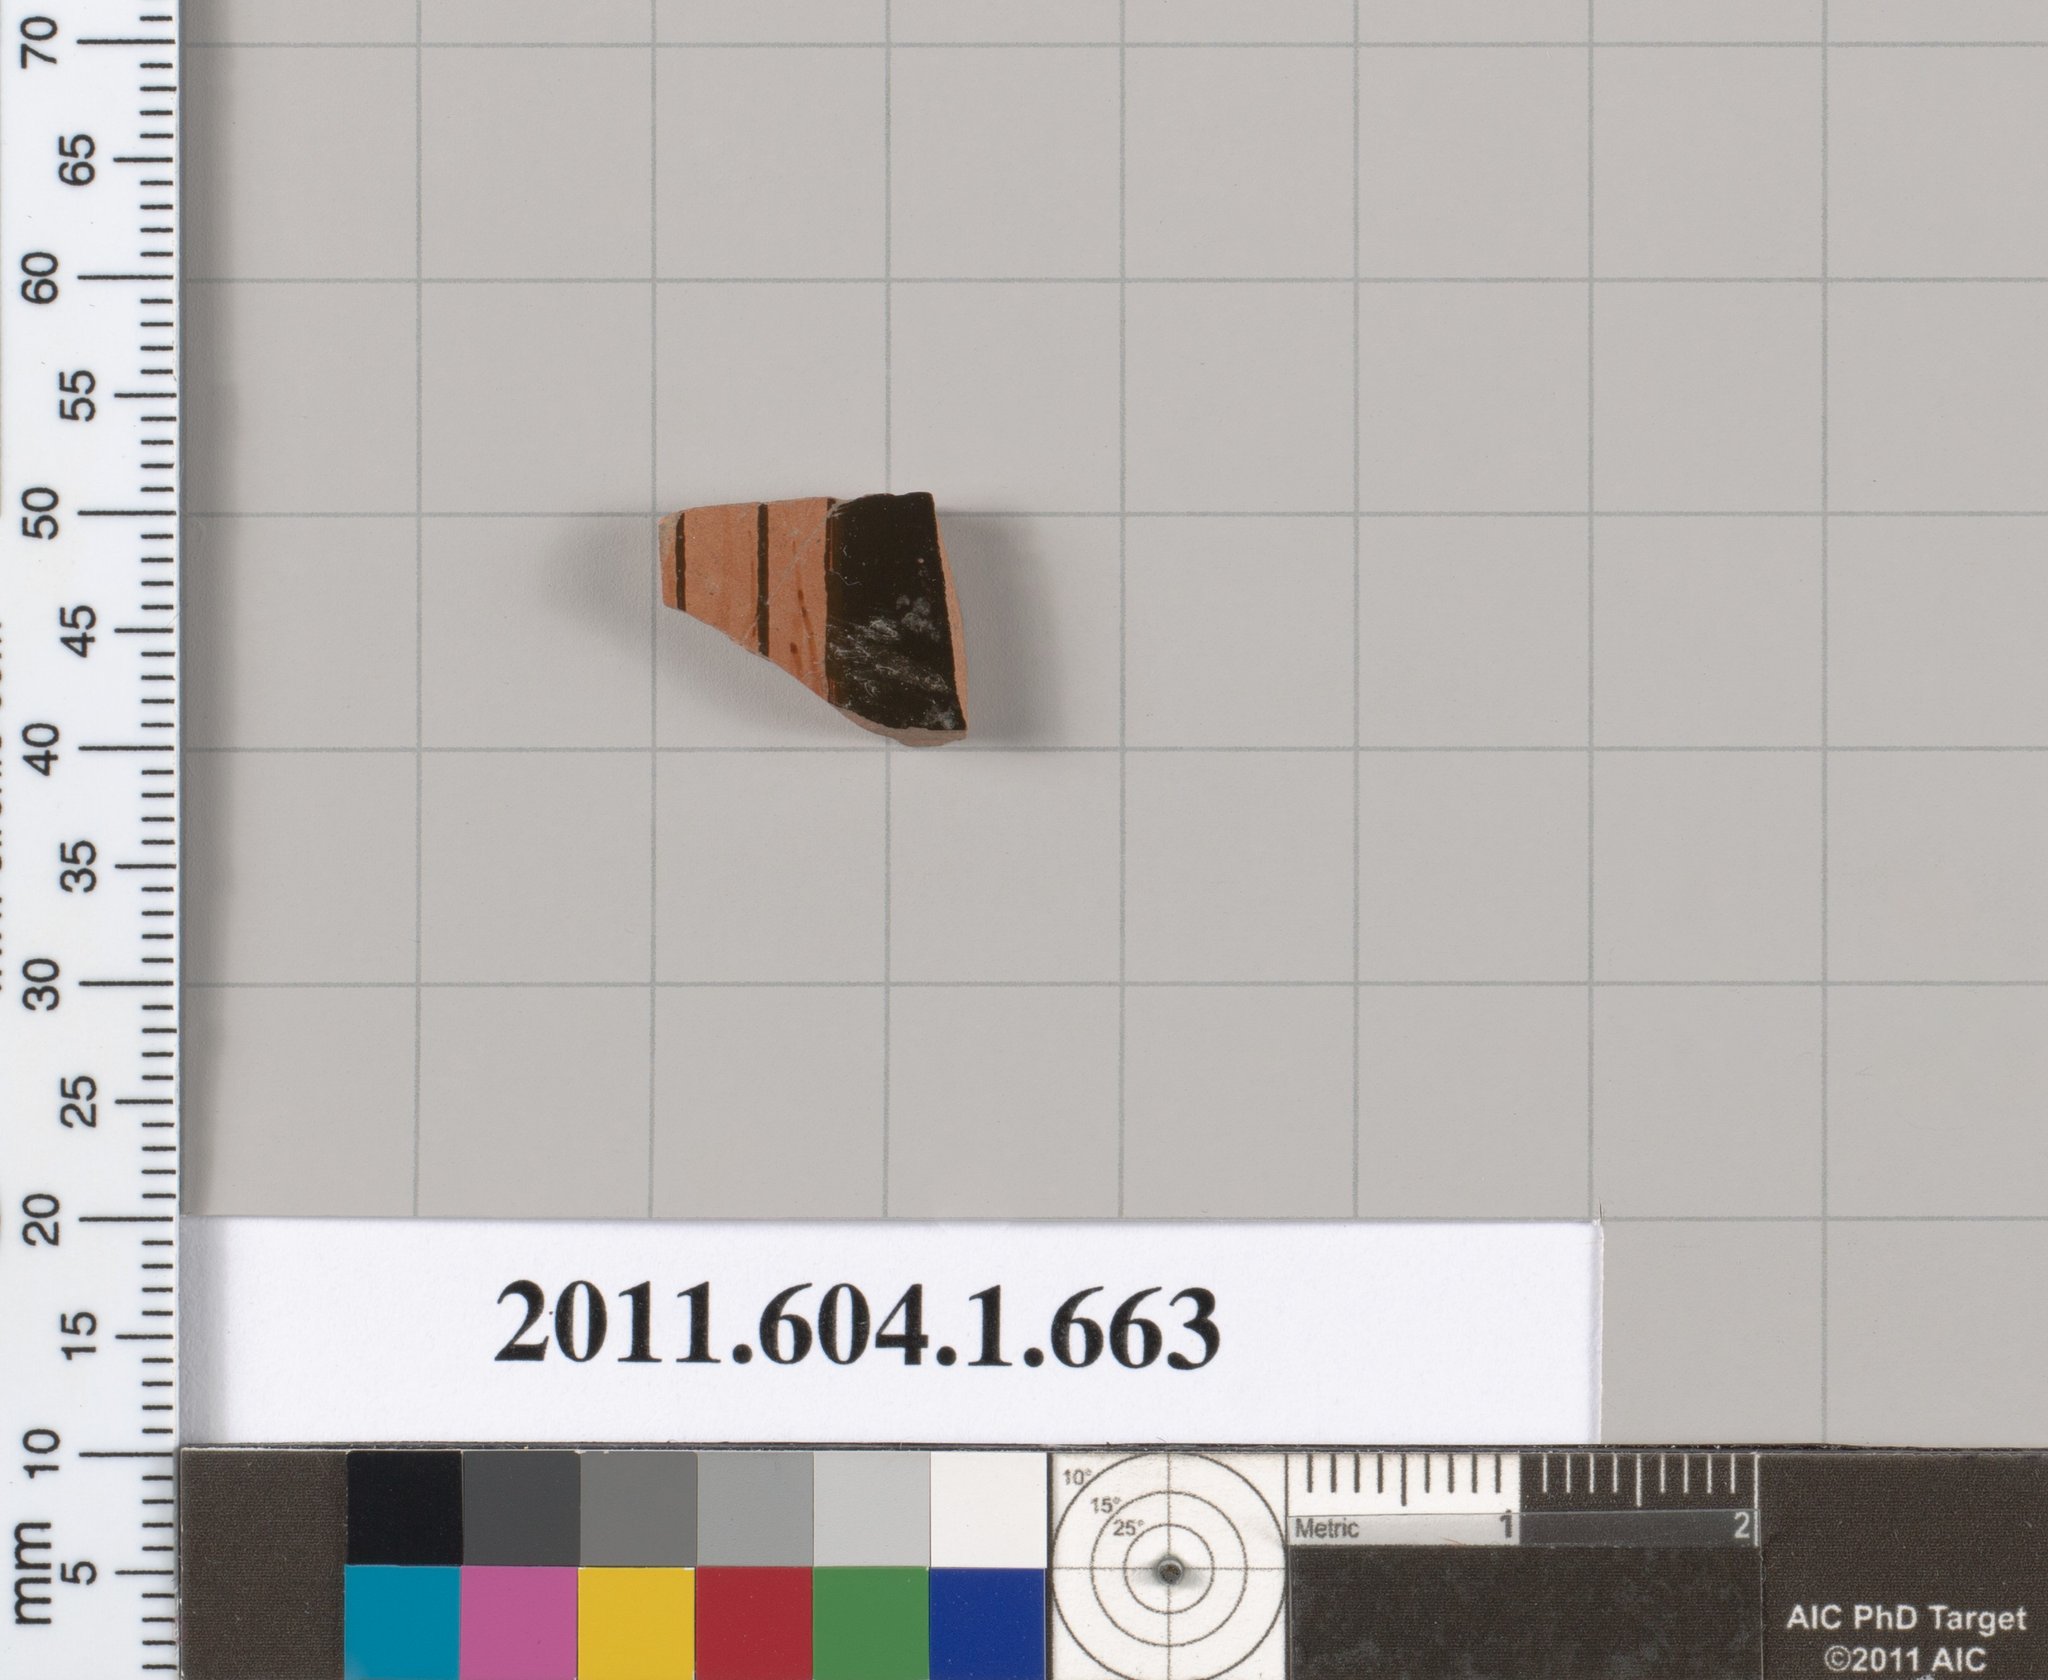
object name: kylix fragment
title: Terracotta fragment of a kylix (drinking cup)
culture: greek, attic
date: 475-451 BCE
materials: terracotta